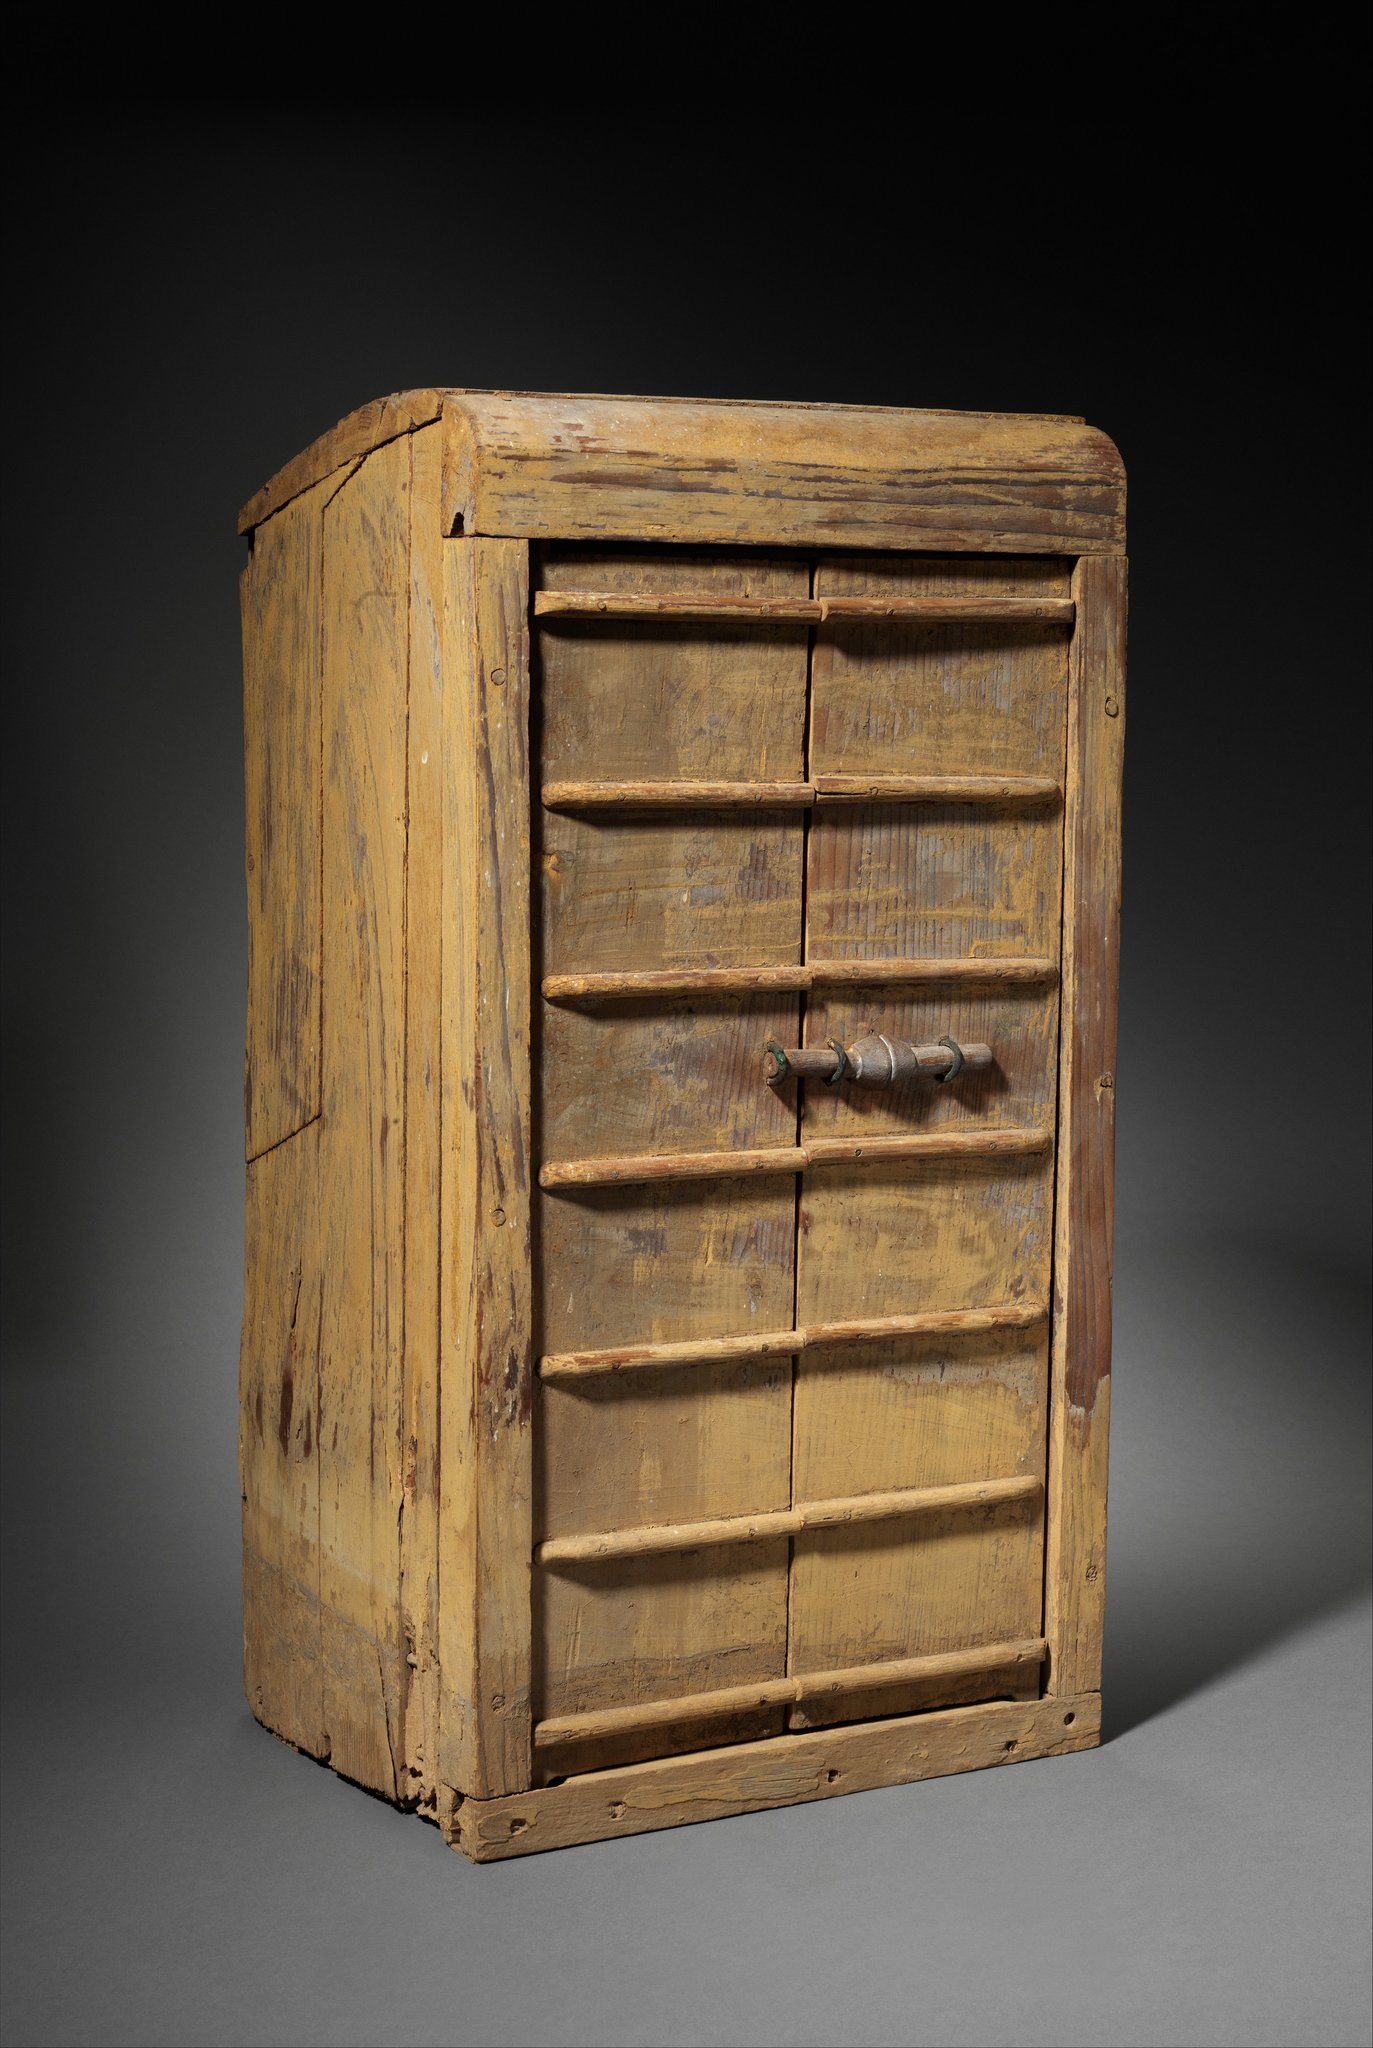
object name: shrine, anubis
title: Shrine for Anubis fetish (Imiut)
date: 1919-1885 BCE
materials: paint, wood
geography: egypt